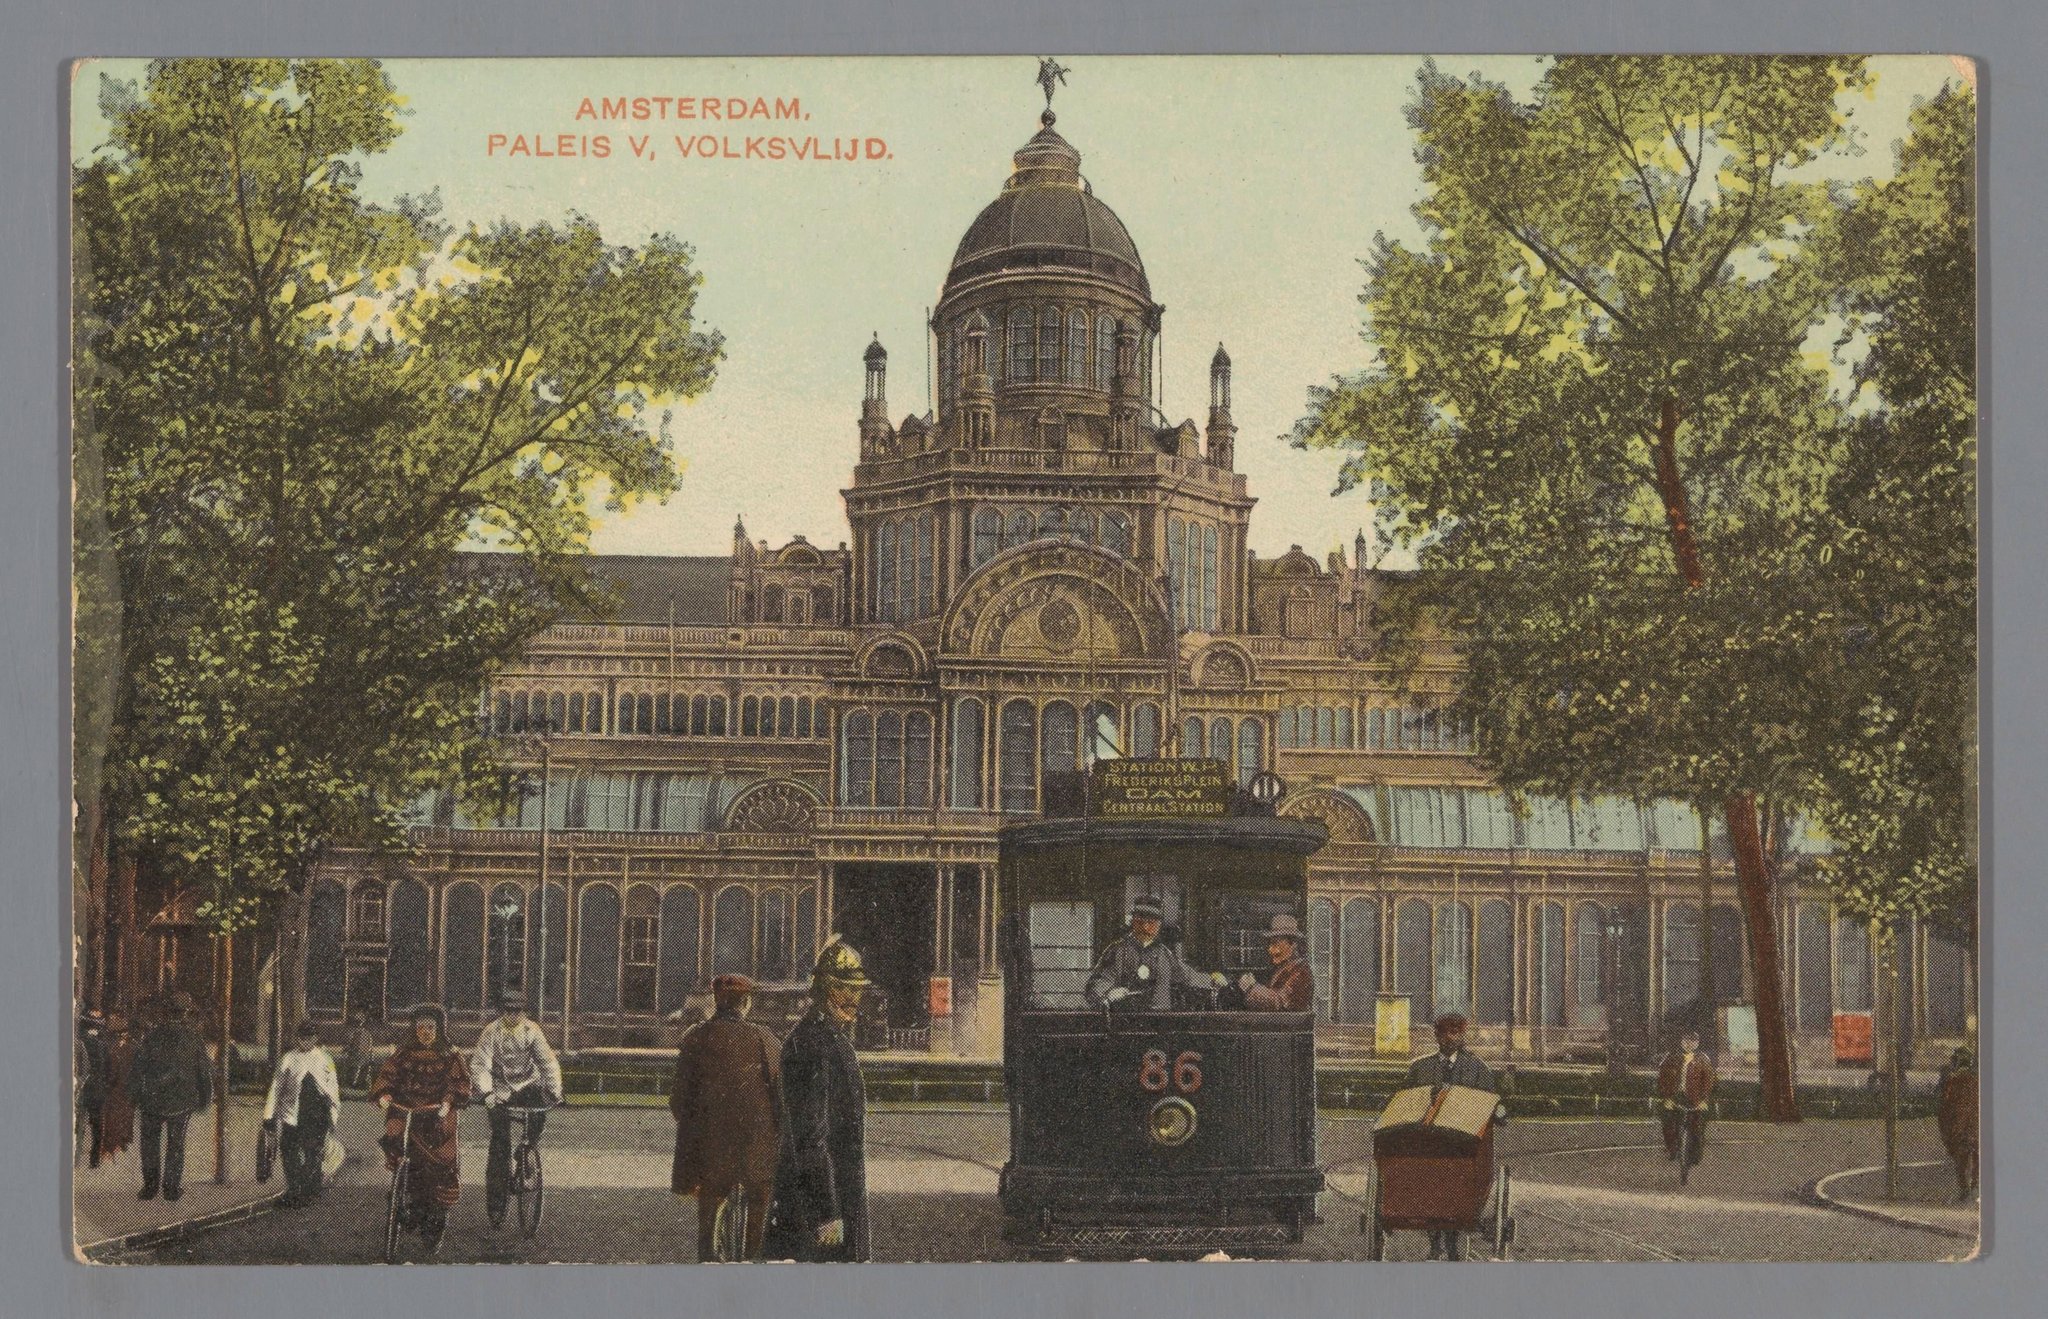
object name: ansichtkaart, prentbriefkaart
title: Amsterdam. Paleis v. Volksvlijd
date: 1900-1920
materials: cardboard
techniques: four-color autotype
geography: amsterdam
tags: palace